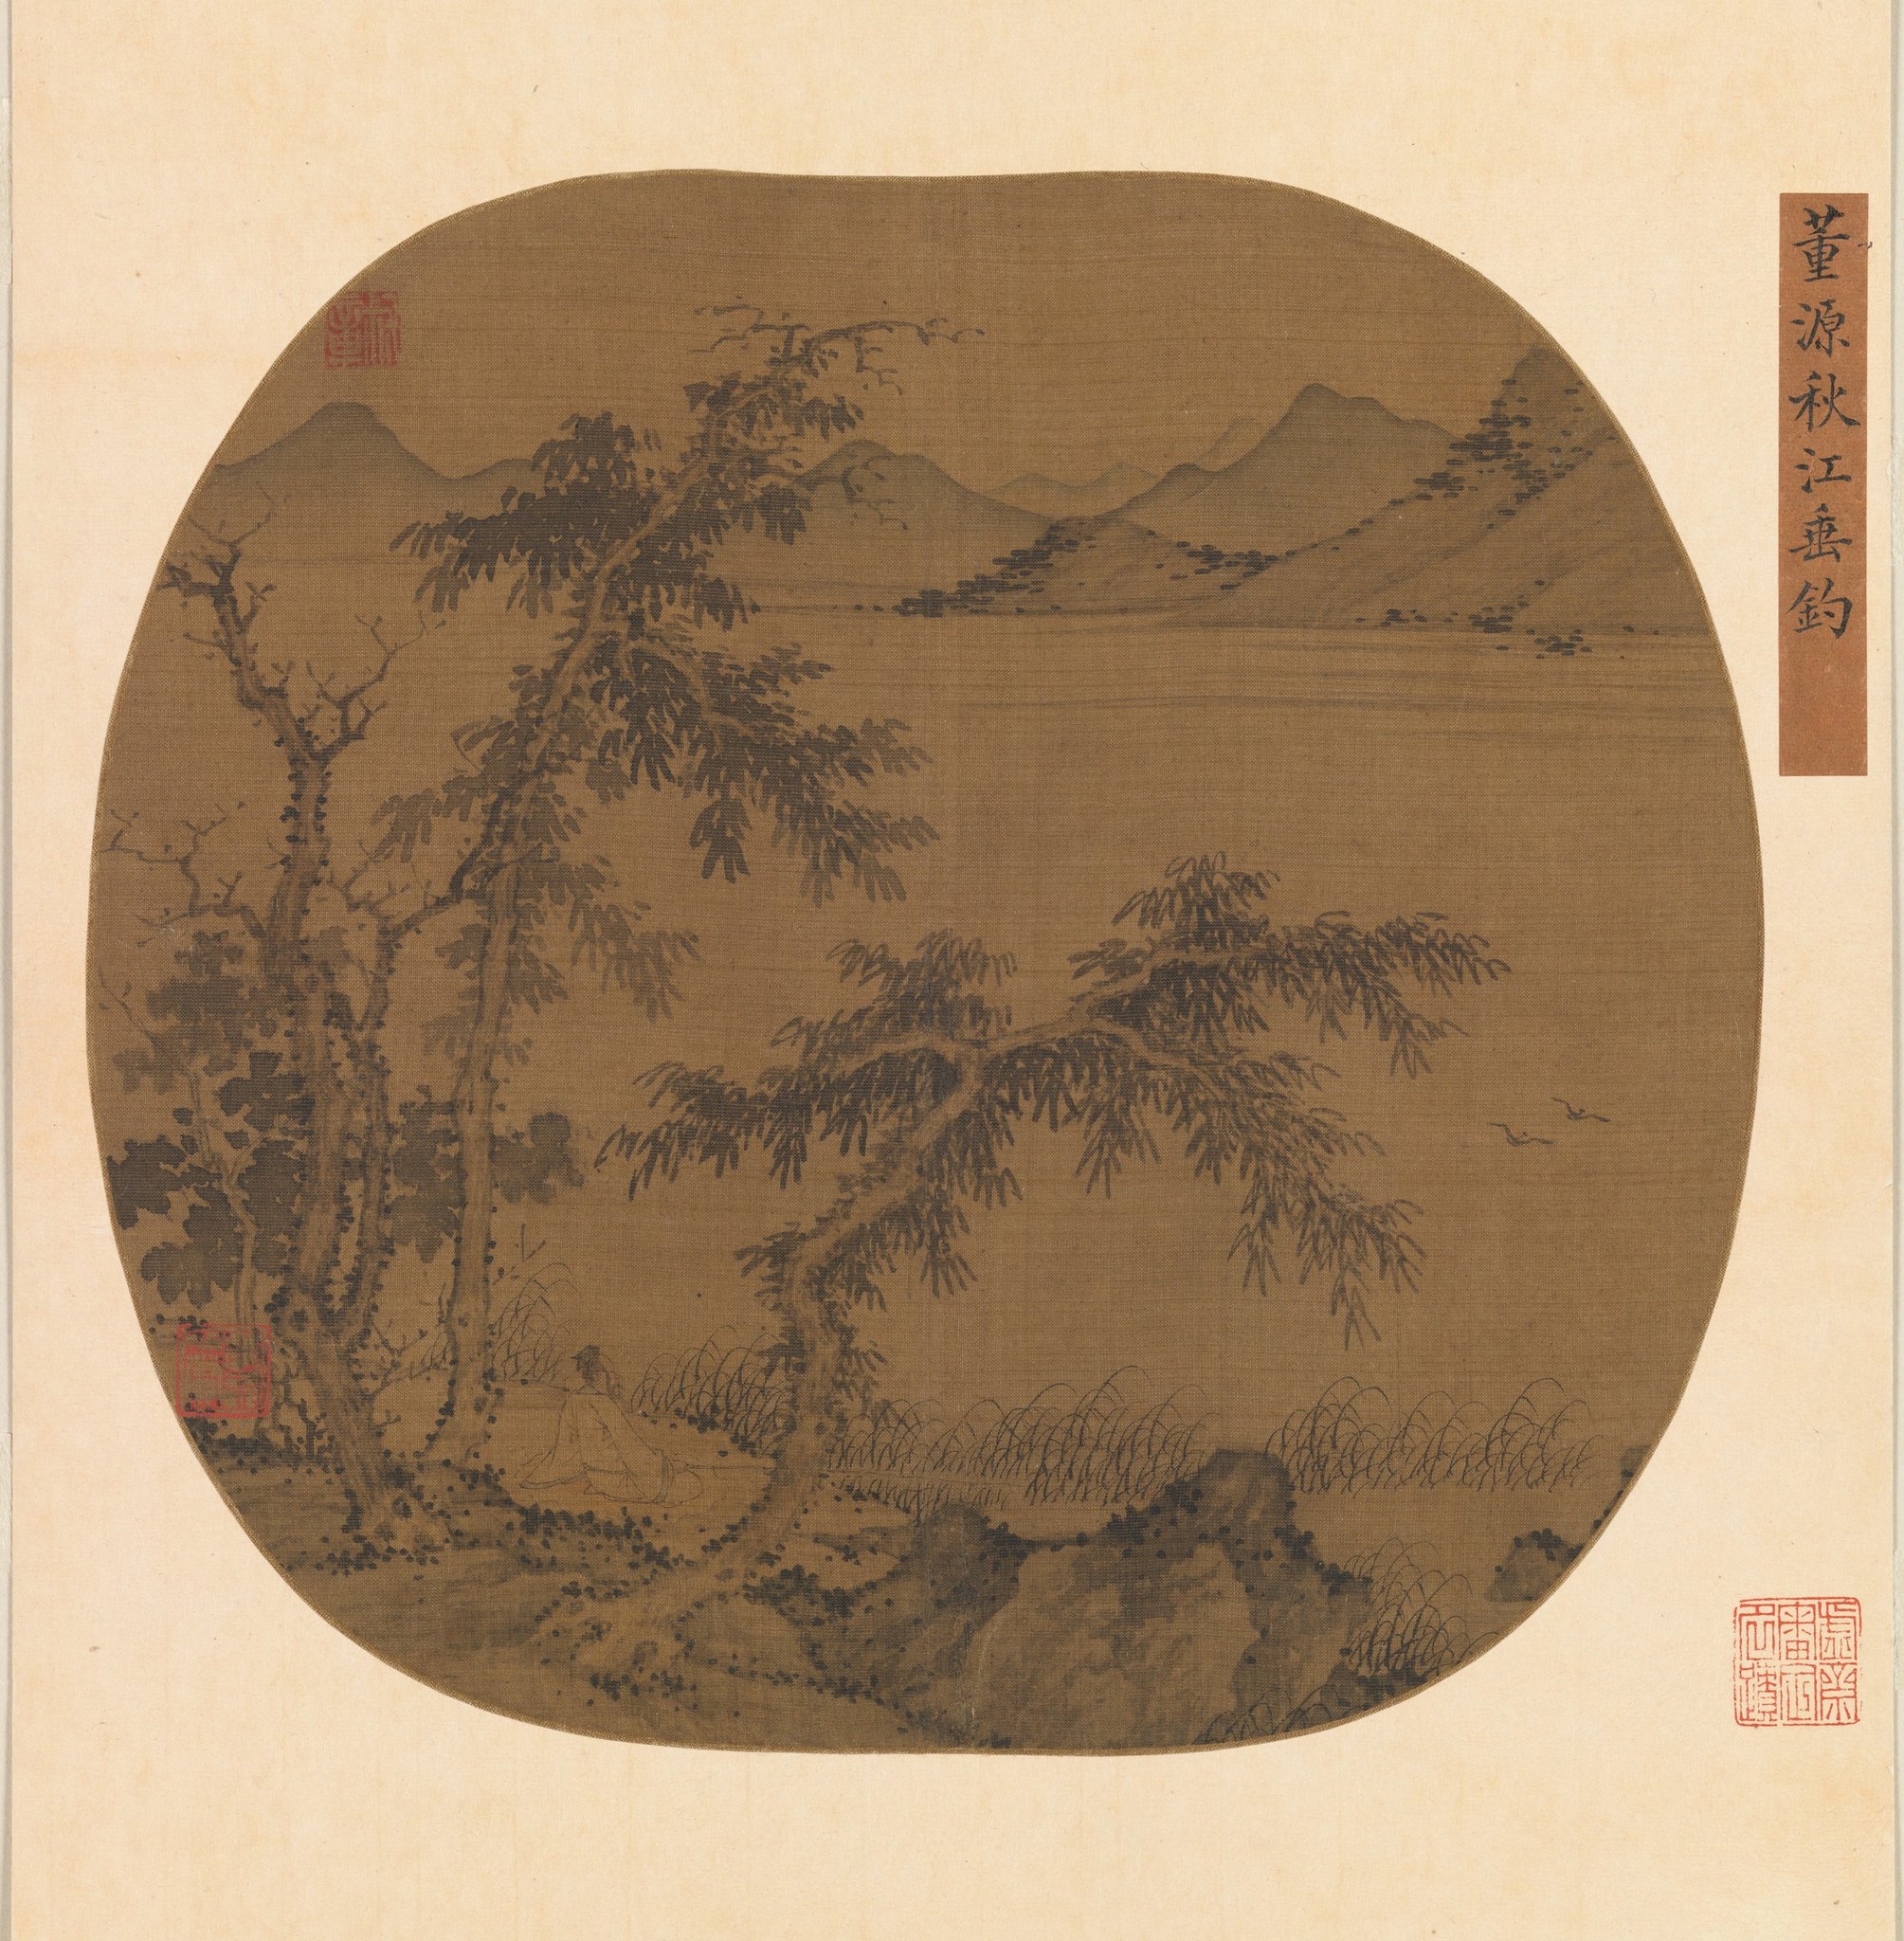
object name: fan mounted a an album leaf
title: Angling in the Autumn River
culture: chinese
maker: sheng zhu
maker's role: artist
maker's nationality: chinese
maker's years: 1300-1400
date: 1370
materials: ink, silk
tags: rivers,landscapes,trees